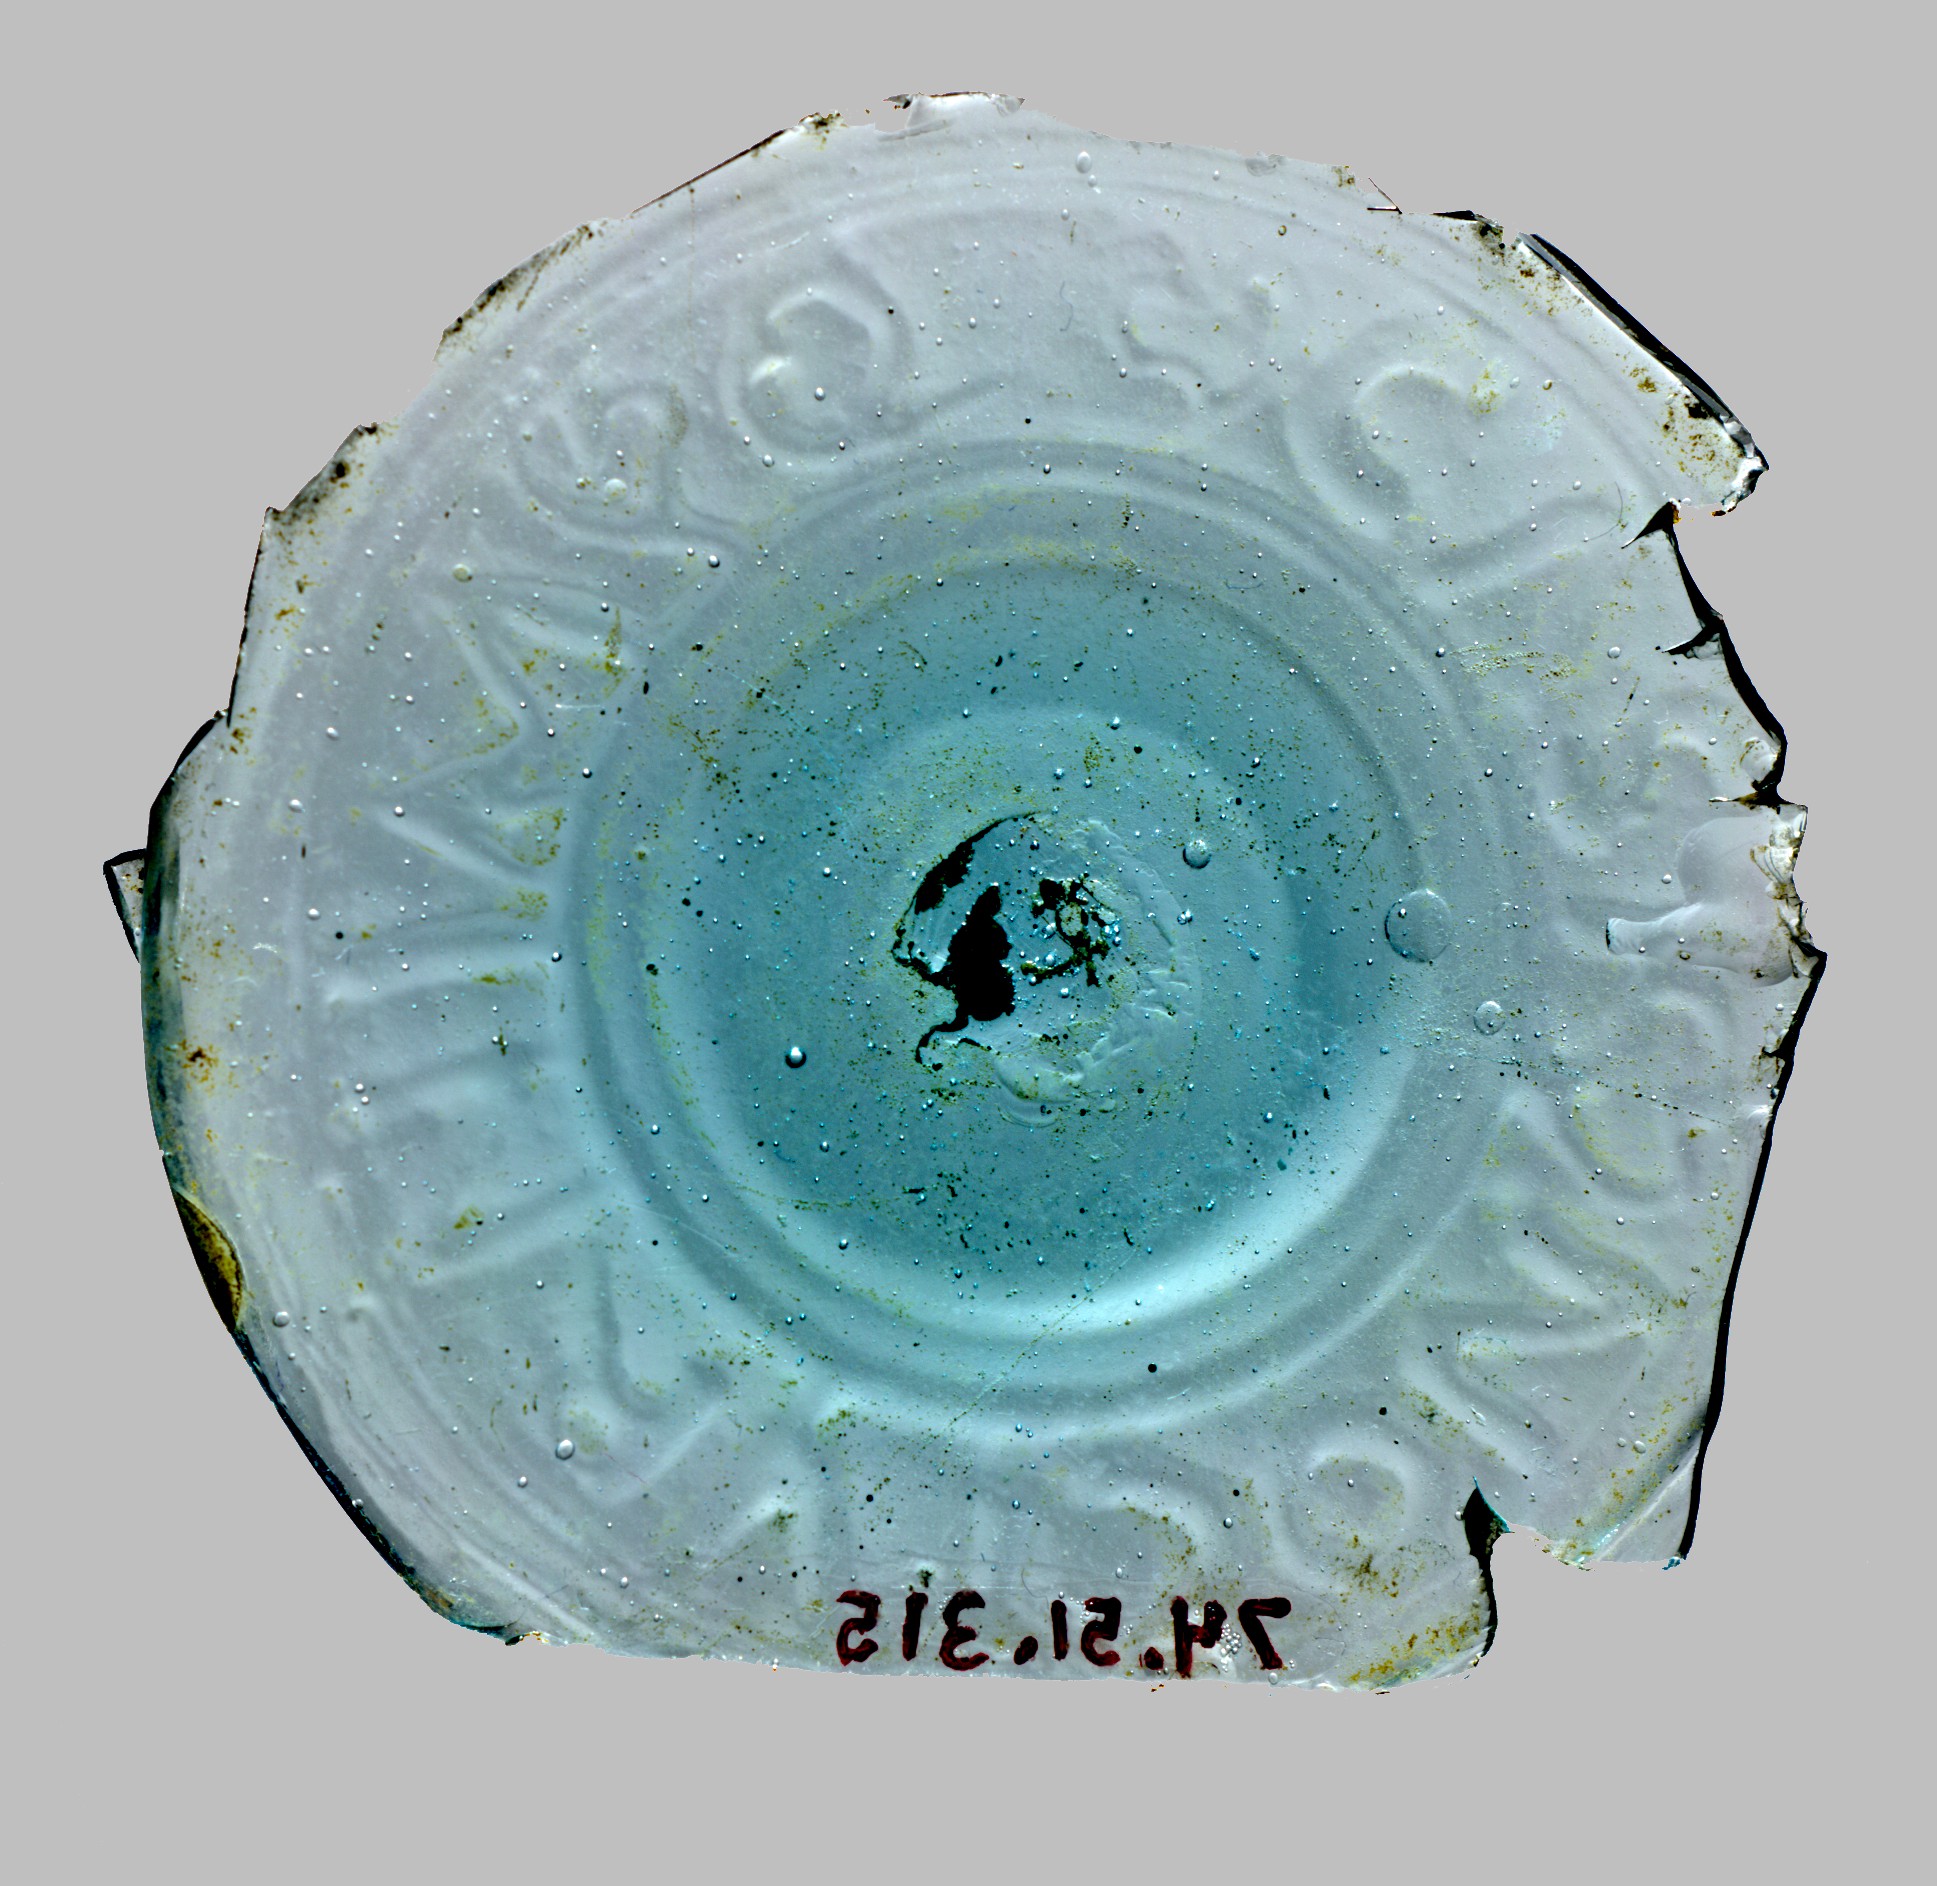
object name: fragment of a base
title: Glass base fragment of a cylindrical bottle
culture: roman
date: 101-300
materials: glass